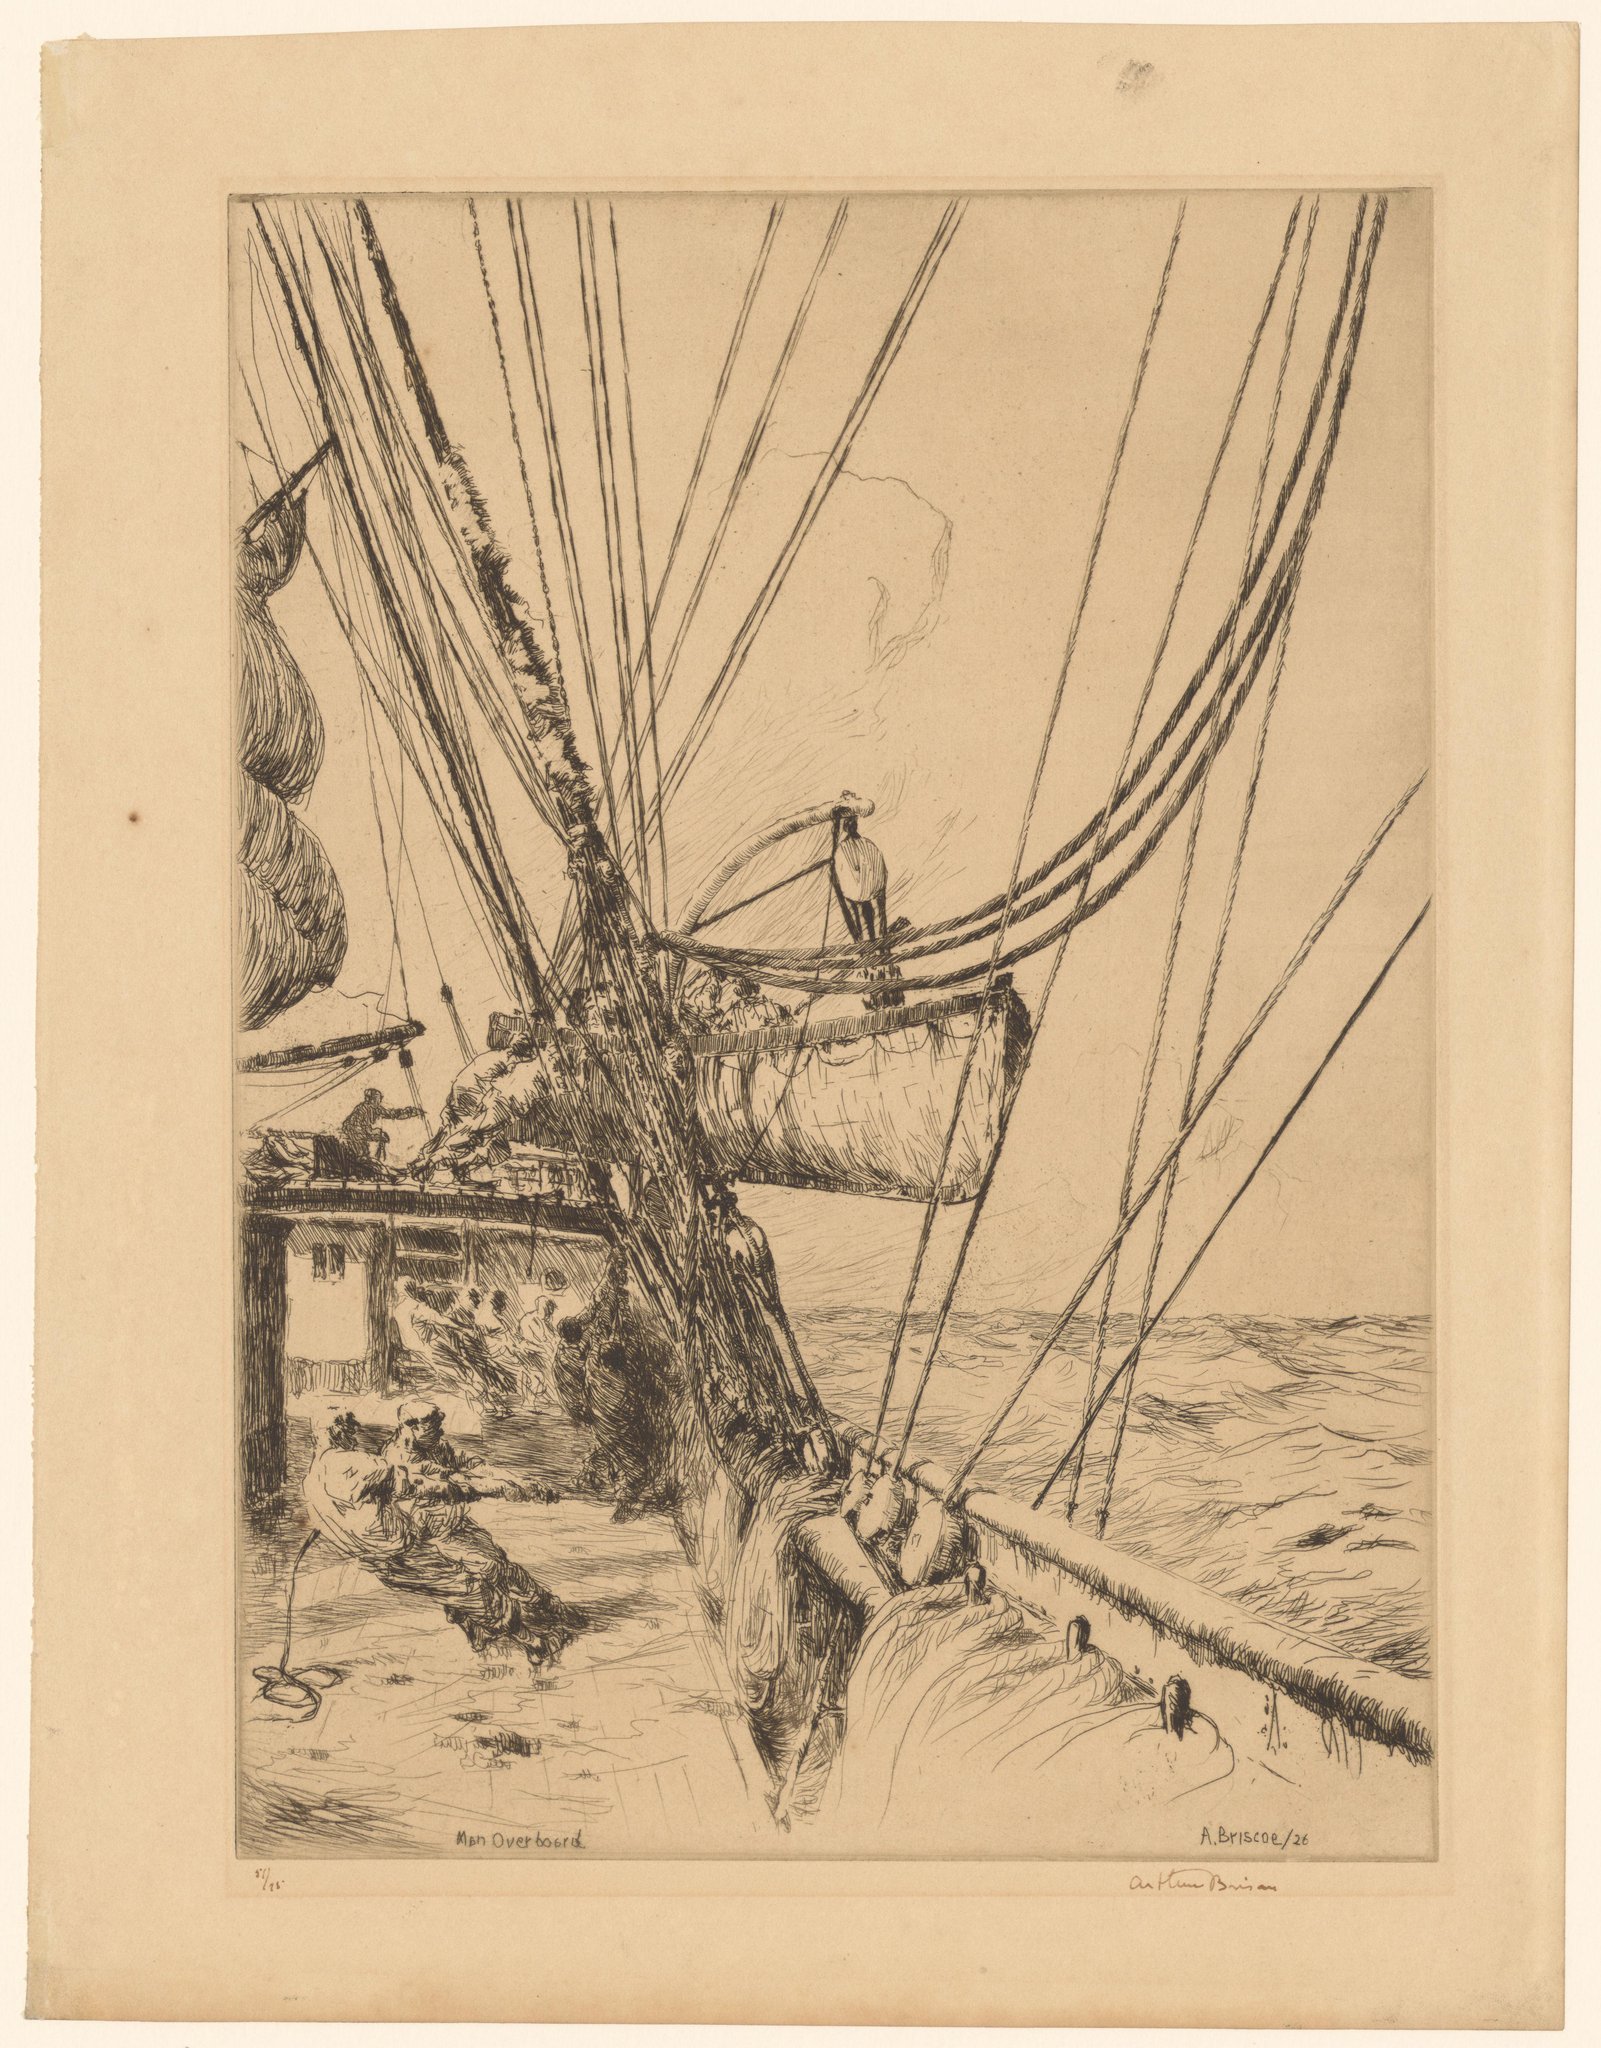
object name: print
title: Man Overboard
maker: arthur john trevor briscoe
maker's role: print maker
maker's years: 1873-1943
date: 1926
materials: paper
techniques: drypoint, etching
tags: rowing-boat, canoe, etc., seaman: sailor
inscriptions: collector's mark: Lugt 2228